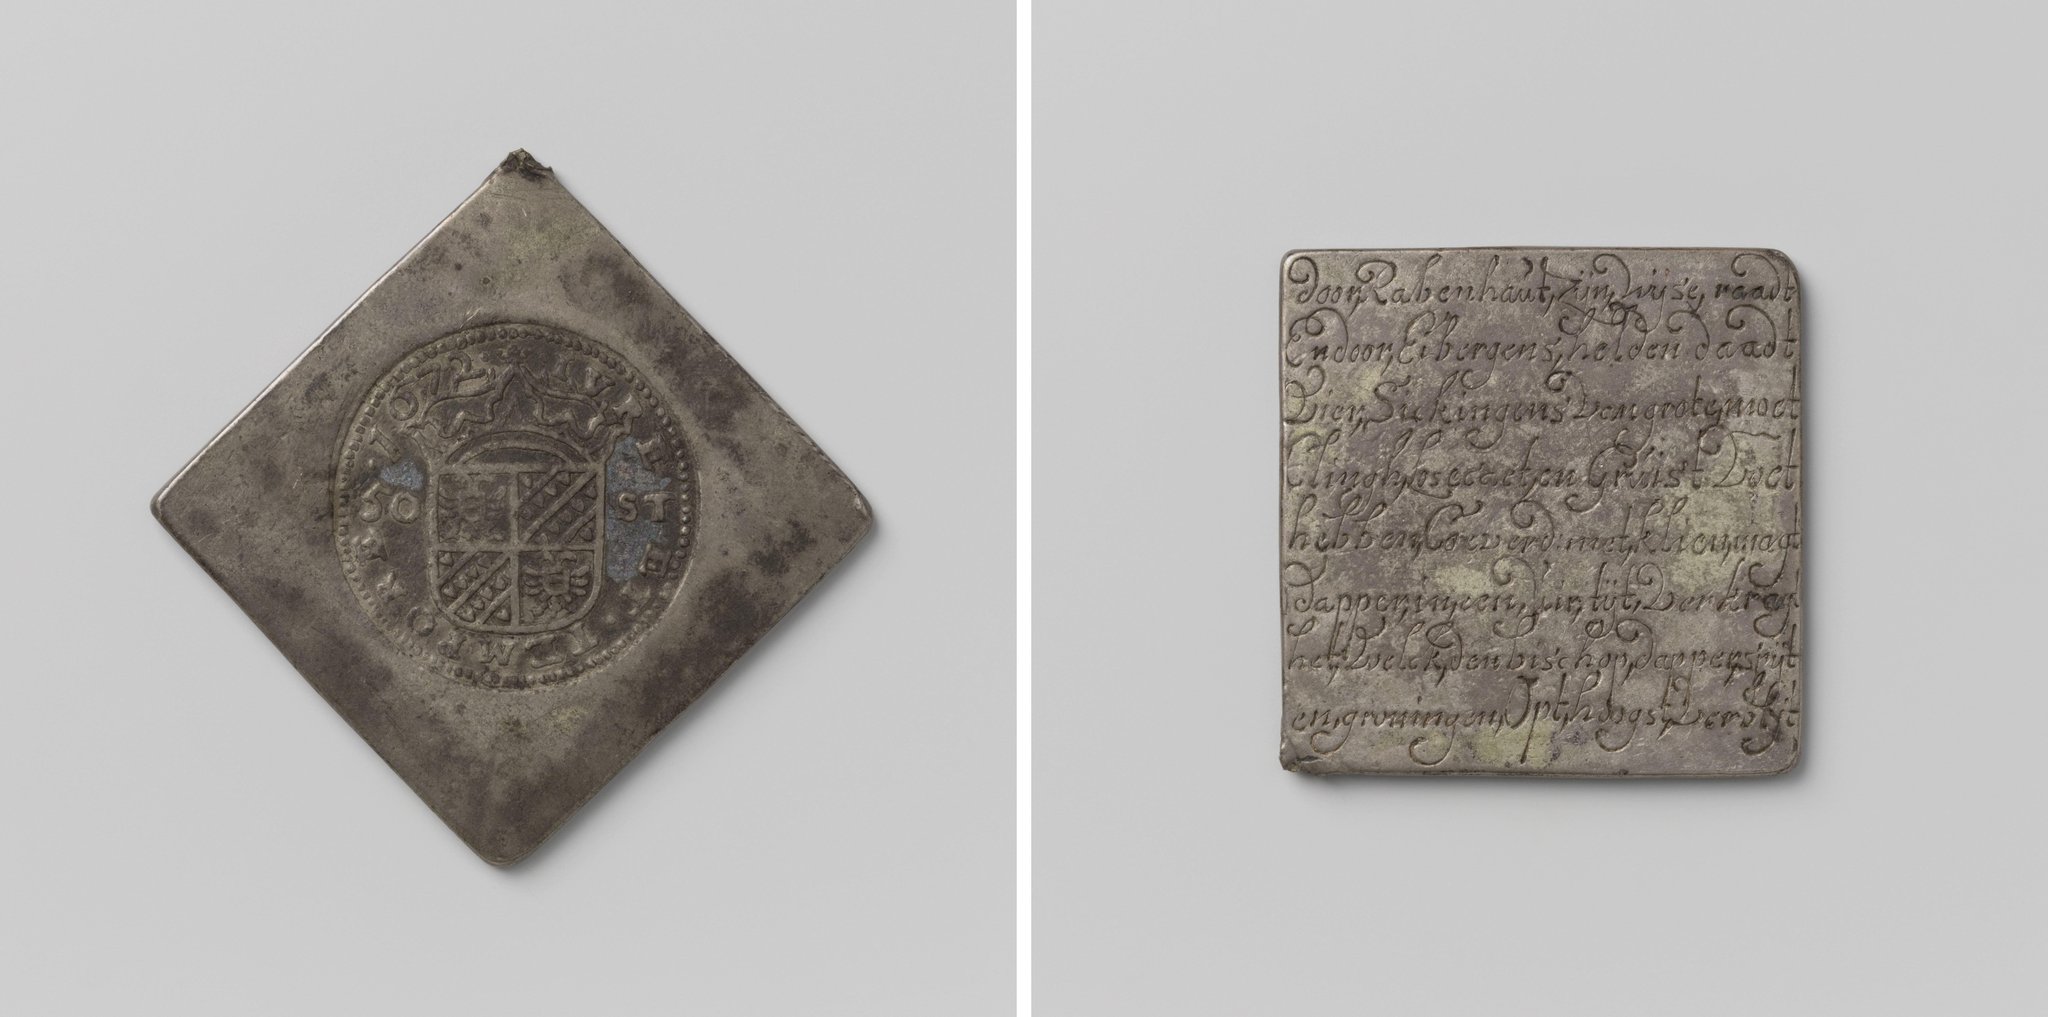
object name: coin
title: Daalder, noodmunt uit Groningen, geslagen tijdens het beleg (voorzien van een tekst over de inname van Coevorden)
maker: Anonymous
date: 1672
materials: silver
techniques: engraving, striking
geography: groningen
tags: coevorden, gouverneur, karl rabenhaupt (baron von sucha), groningen, beleg van groningen (1672), inname van coevorden (1672)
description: ruitvormige noodmunt van Groningen, met afgeronde hoeken. Voorzijde: gekroond wapenschild (kleine stempel) tussen waardeaanduiding binnen omschrift. Keerzijde: opschrift "door Rabenhaupt zijn wijse raadt En door Eibergens helden daadt Vier Sickingens van grote moet Clingh, Losecaet en Gruis t Voet hebben Coeverd: met klien magt dapper in een uir tijt Verkragt het Welck den bischop dapper spijt en groningen Opt hoogst Verblyt"